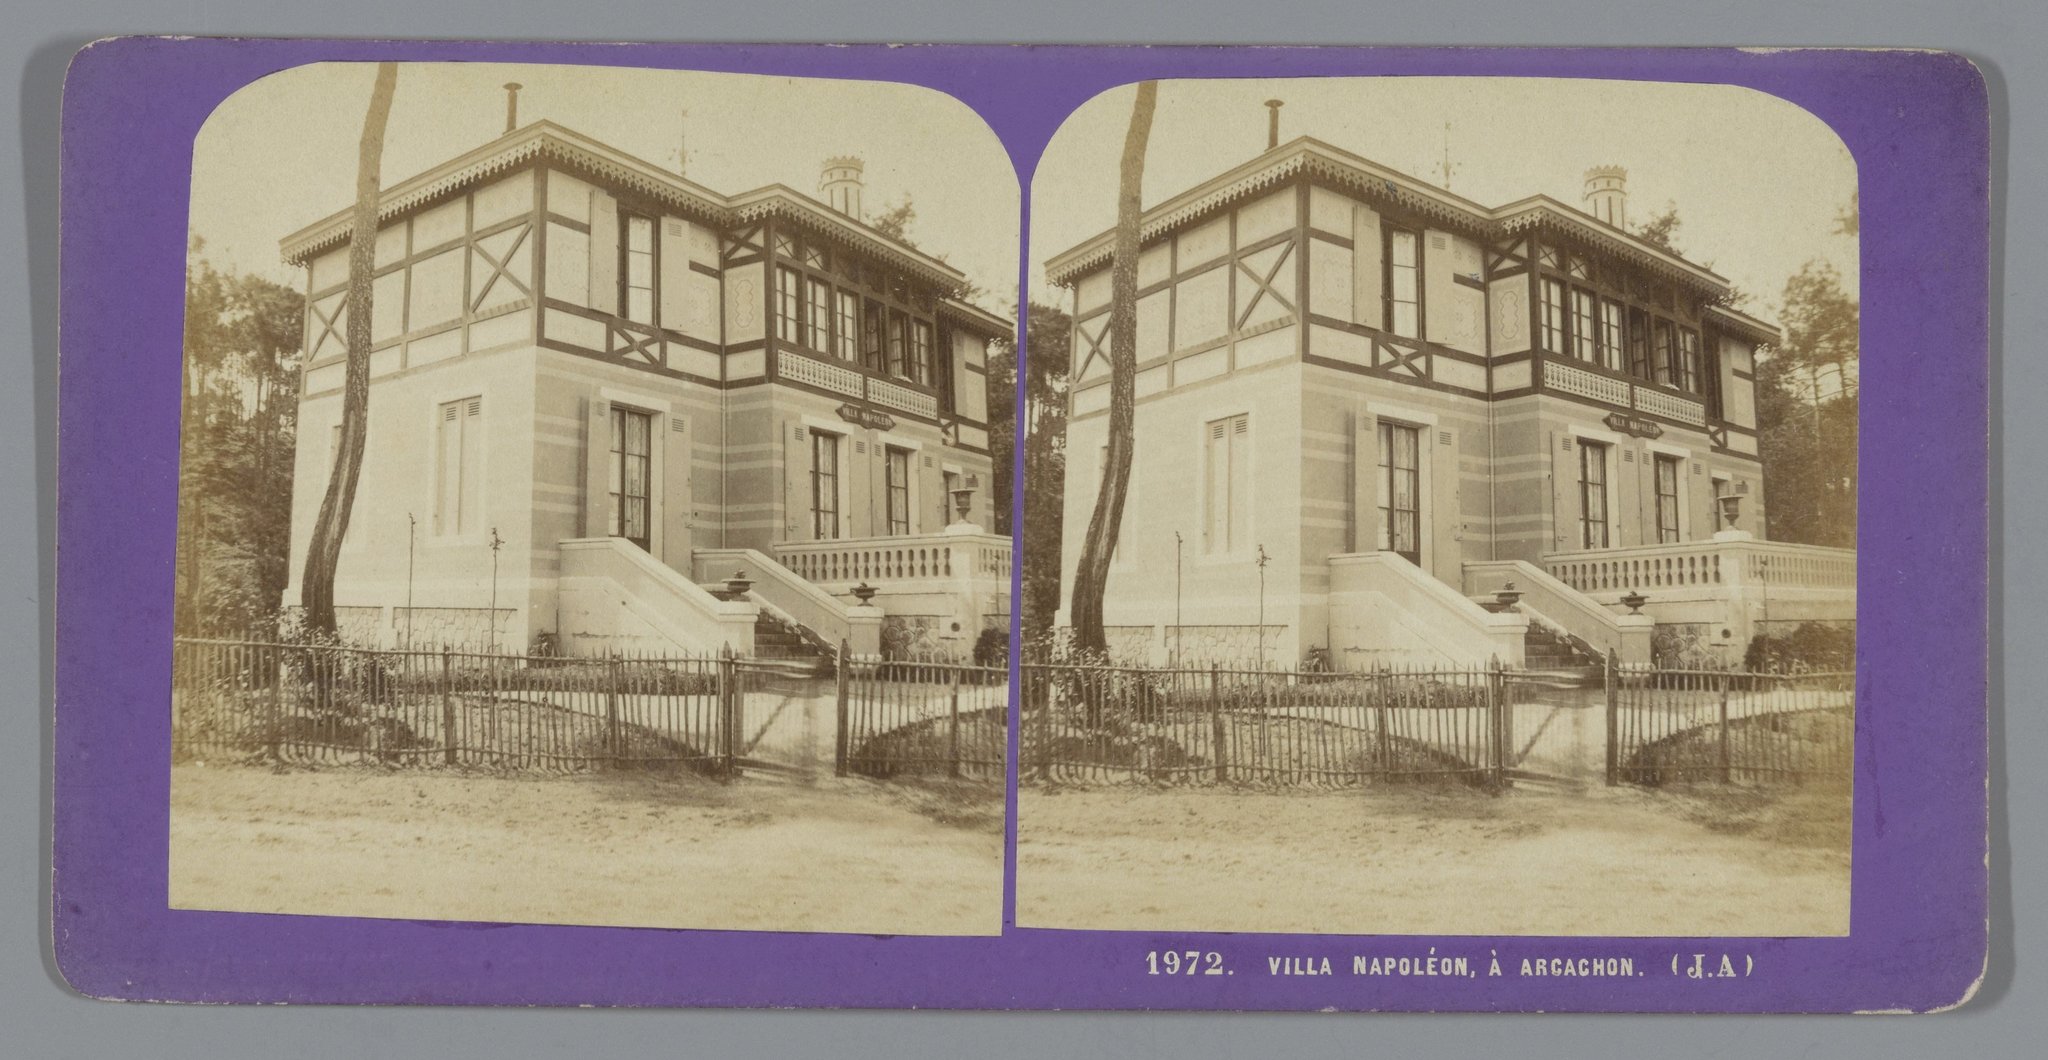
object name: stereograph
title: Villa Napoléon, à Arcachon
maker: jean andrieu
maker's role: fotograaf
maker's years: 1816-1872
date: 1862-1876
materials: cardboard, photographic support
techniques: albumen print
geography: arcachon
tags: rural housing, e.g. country-house, villa, cottage, façade (of house or building)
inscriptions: number: ‘1972’